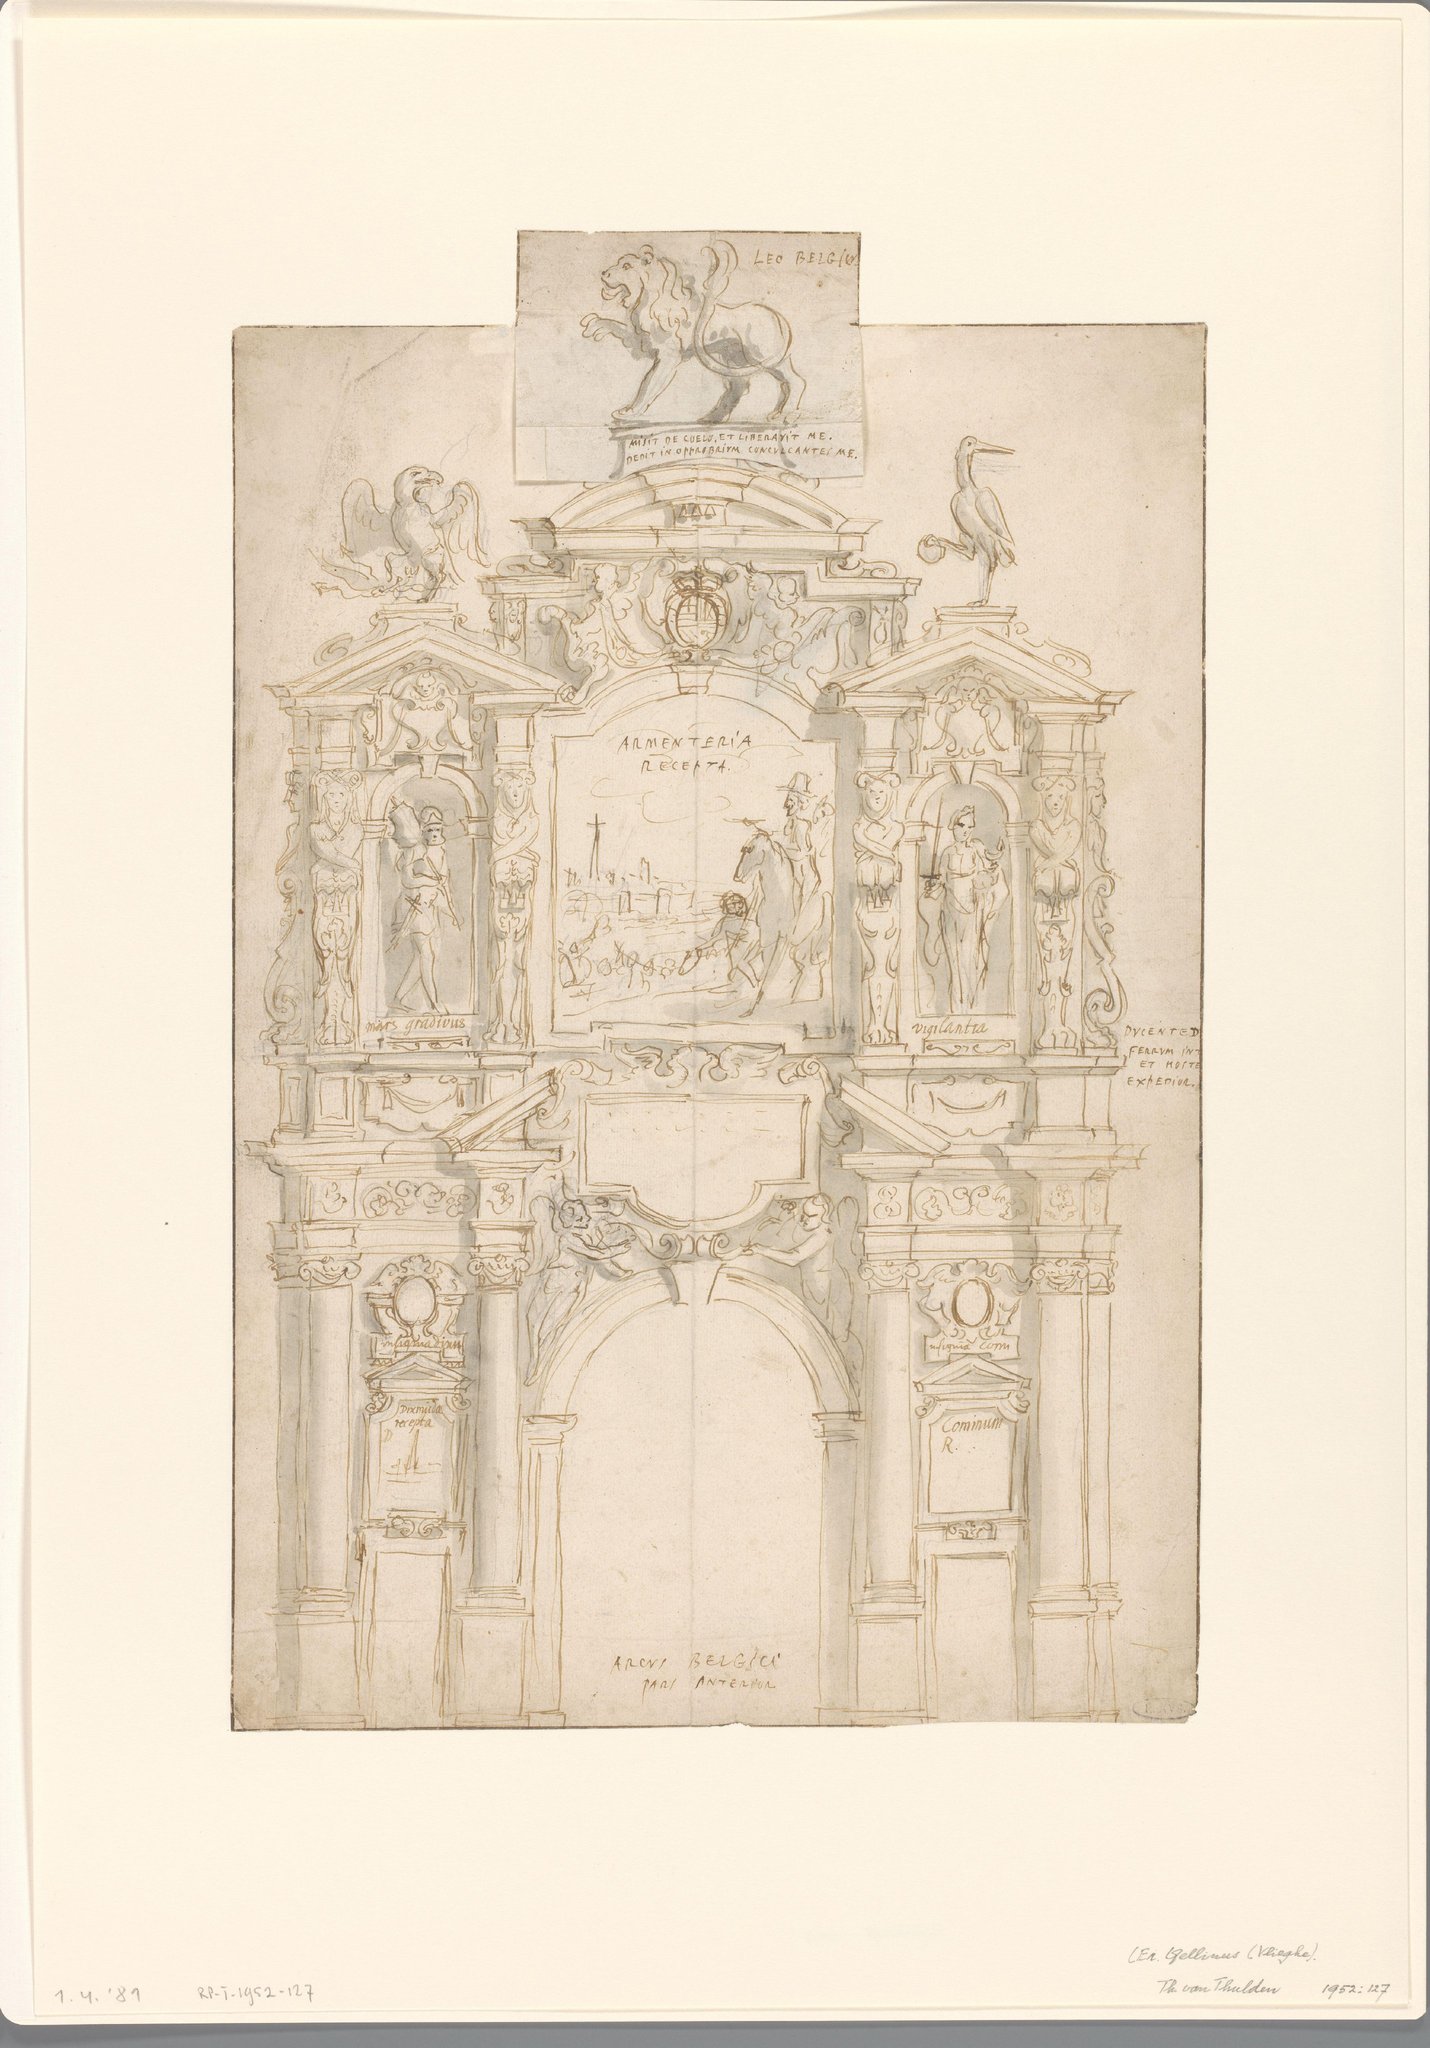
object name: drawing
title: Ontwerp voor een ereboog voor aartshertog Leopold Willem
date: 1646-1648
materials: chalk, ink, paper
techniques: brush, pen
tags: vienna, leopold willem van oostenrijk (landvoogd der zuidelijke nederlanden), triumphal arch